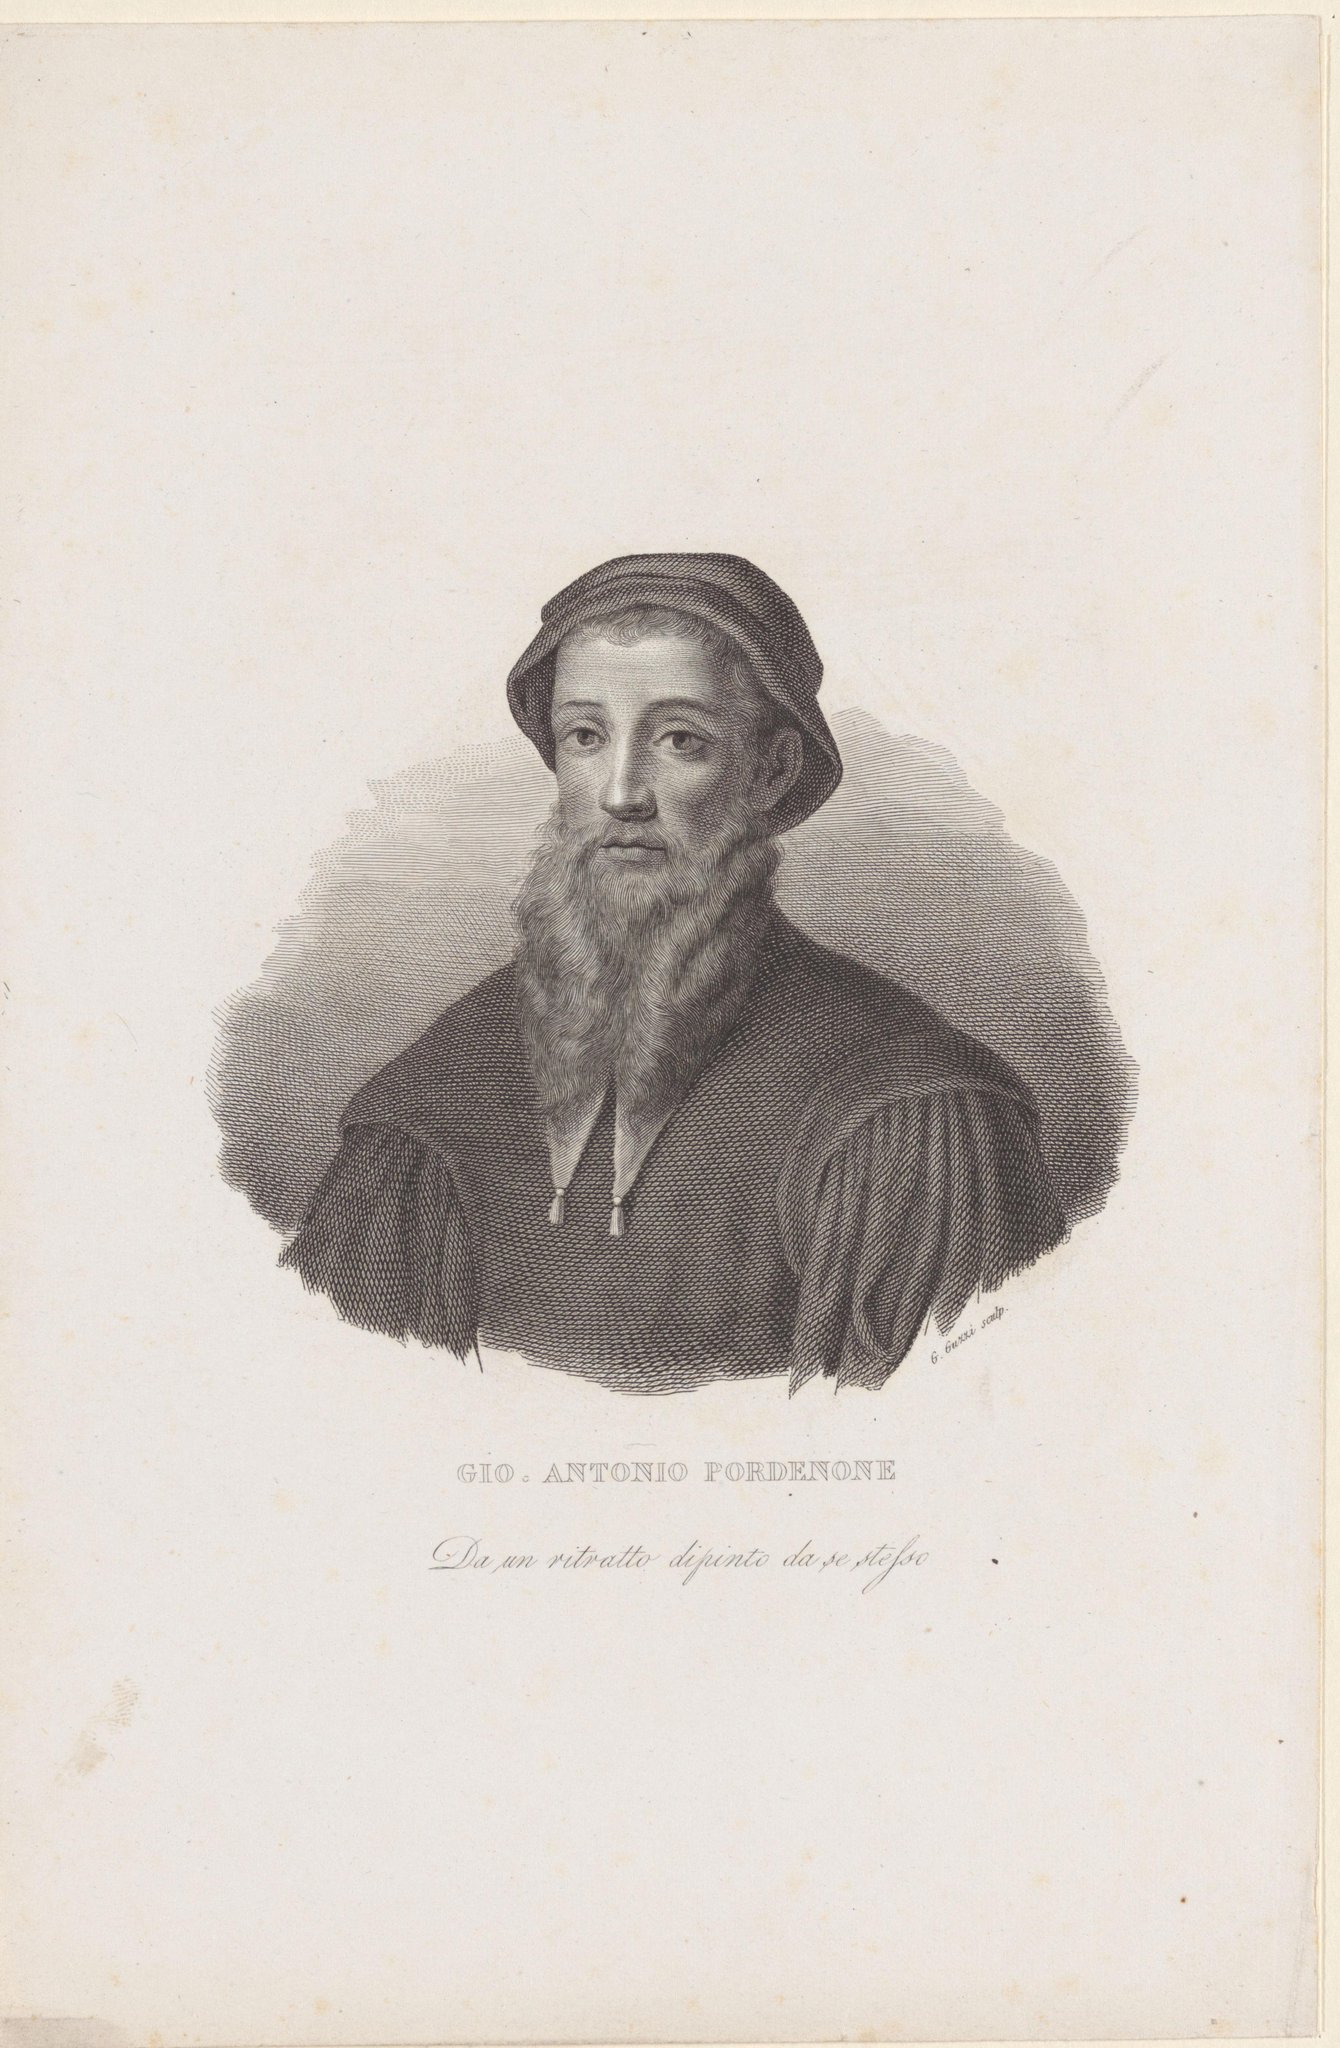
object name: print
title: Portret van schilder Giovanni Antonio Pordenone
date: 1834-1842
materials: paper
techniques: engraving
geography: italy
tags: painter, print maker, draughtsman, pordenone, historical persons, portrait, self-portrait of artist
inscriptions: collector's mark: Lugt 2228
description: Naar geschilderd zelfportret door Pordenone in de Galleria degli Uffizi te Florence.